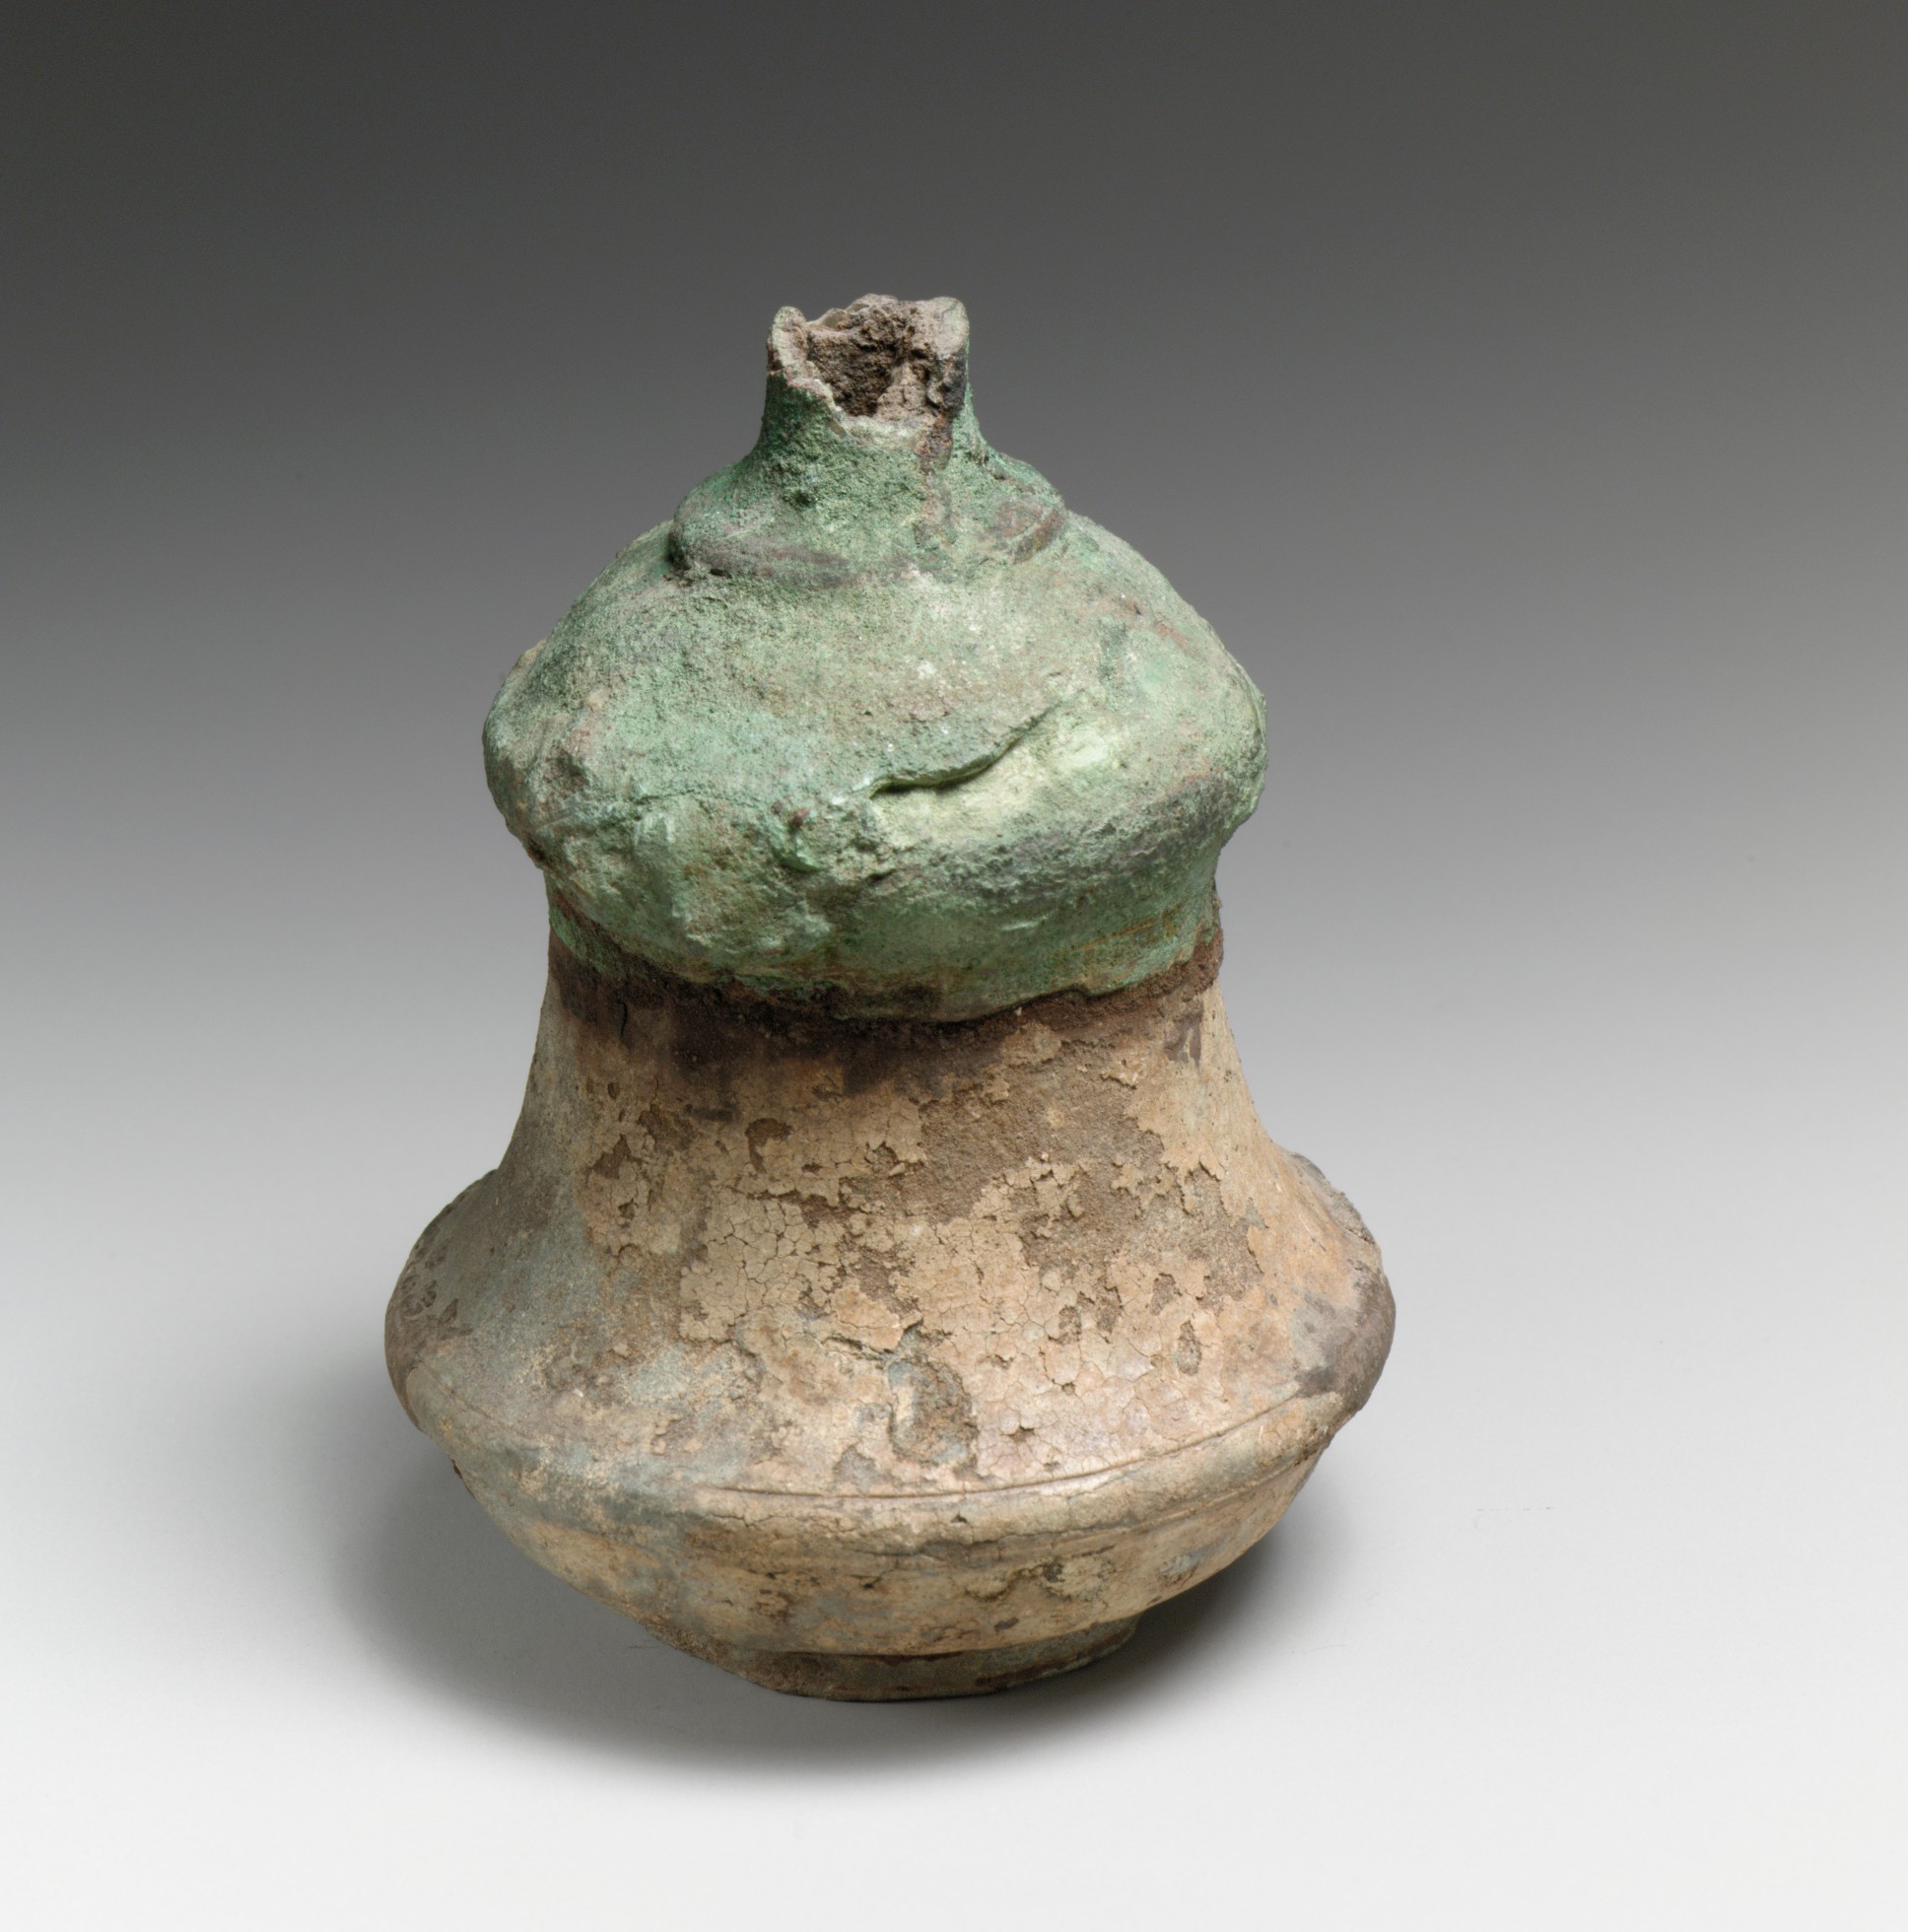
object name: vase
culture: roman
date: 1-100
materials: bronze